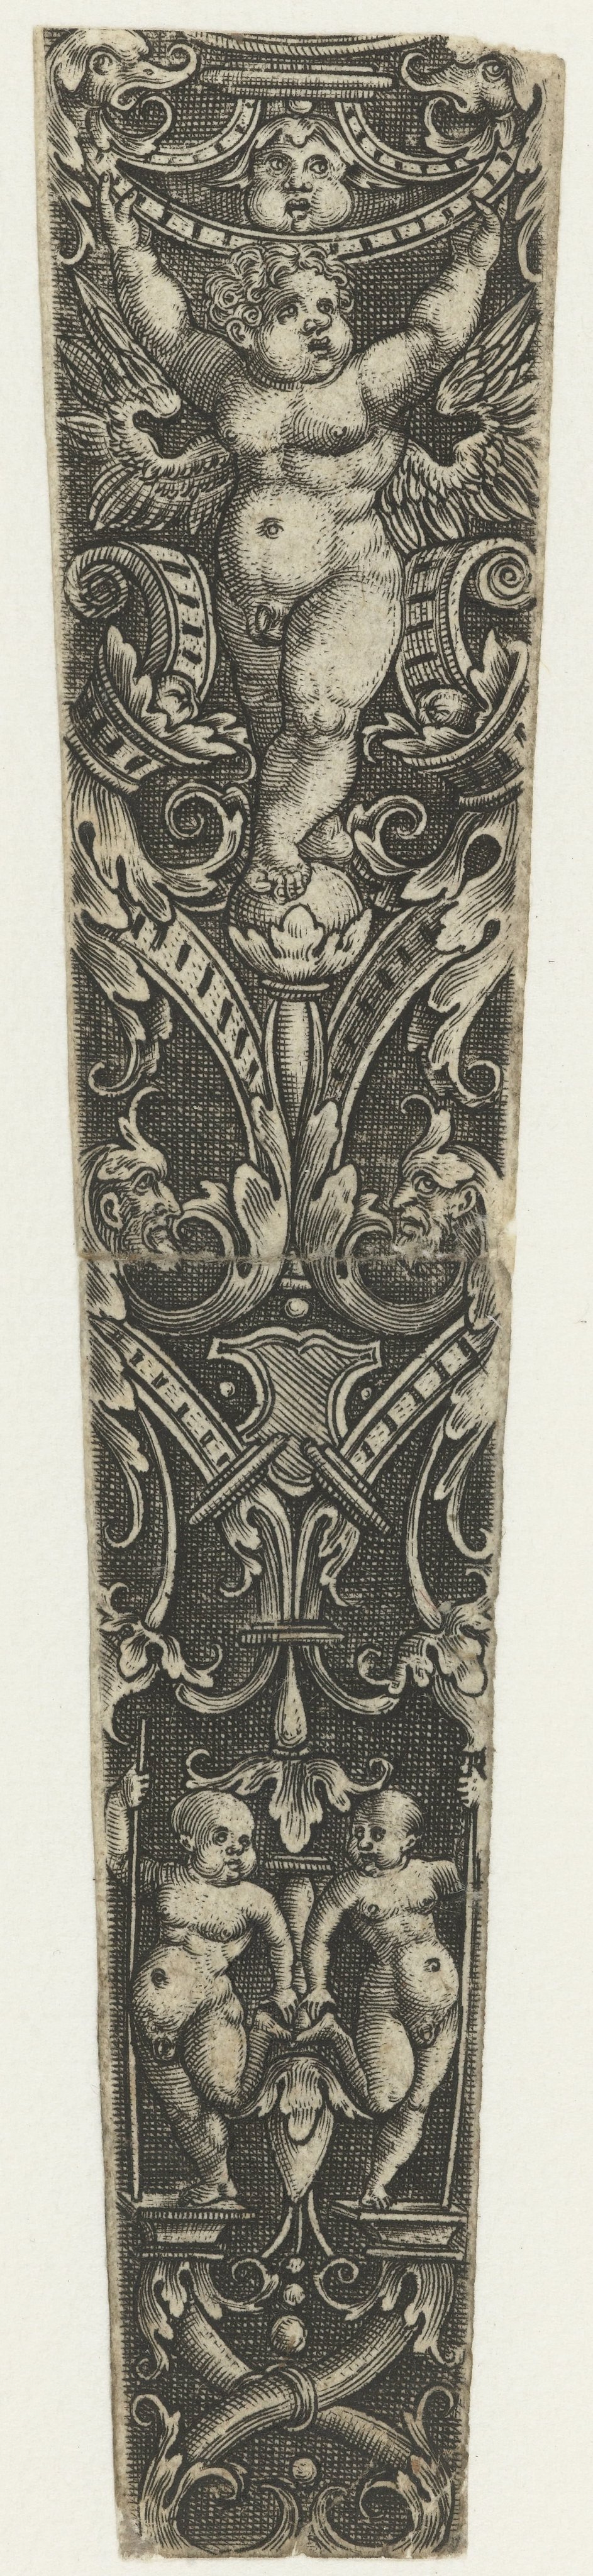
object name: print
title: Ornament met putto en kinderen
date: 1520-1562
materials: paper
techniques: engraving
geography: low countries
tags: child, cupids: 'amores', 'amoretti', 'putti'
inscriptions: collector's mark: Lugt 240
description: Onderste deel van een ontwerp voor een dolkschede. Twee kinderen leunend op stokken, daarboven een putto op voluten en bladranken.